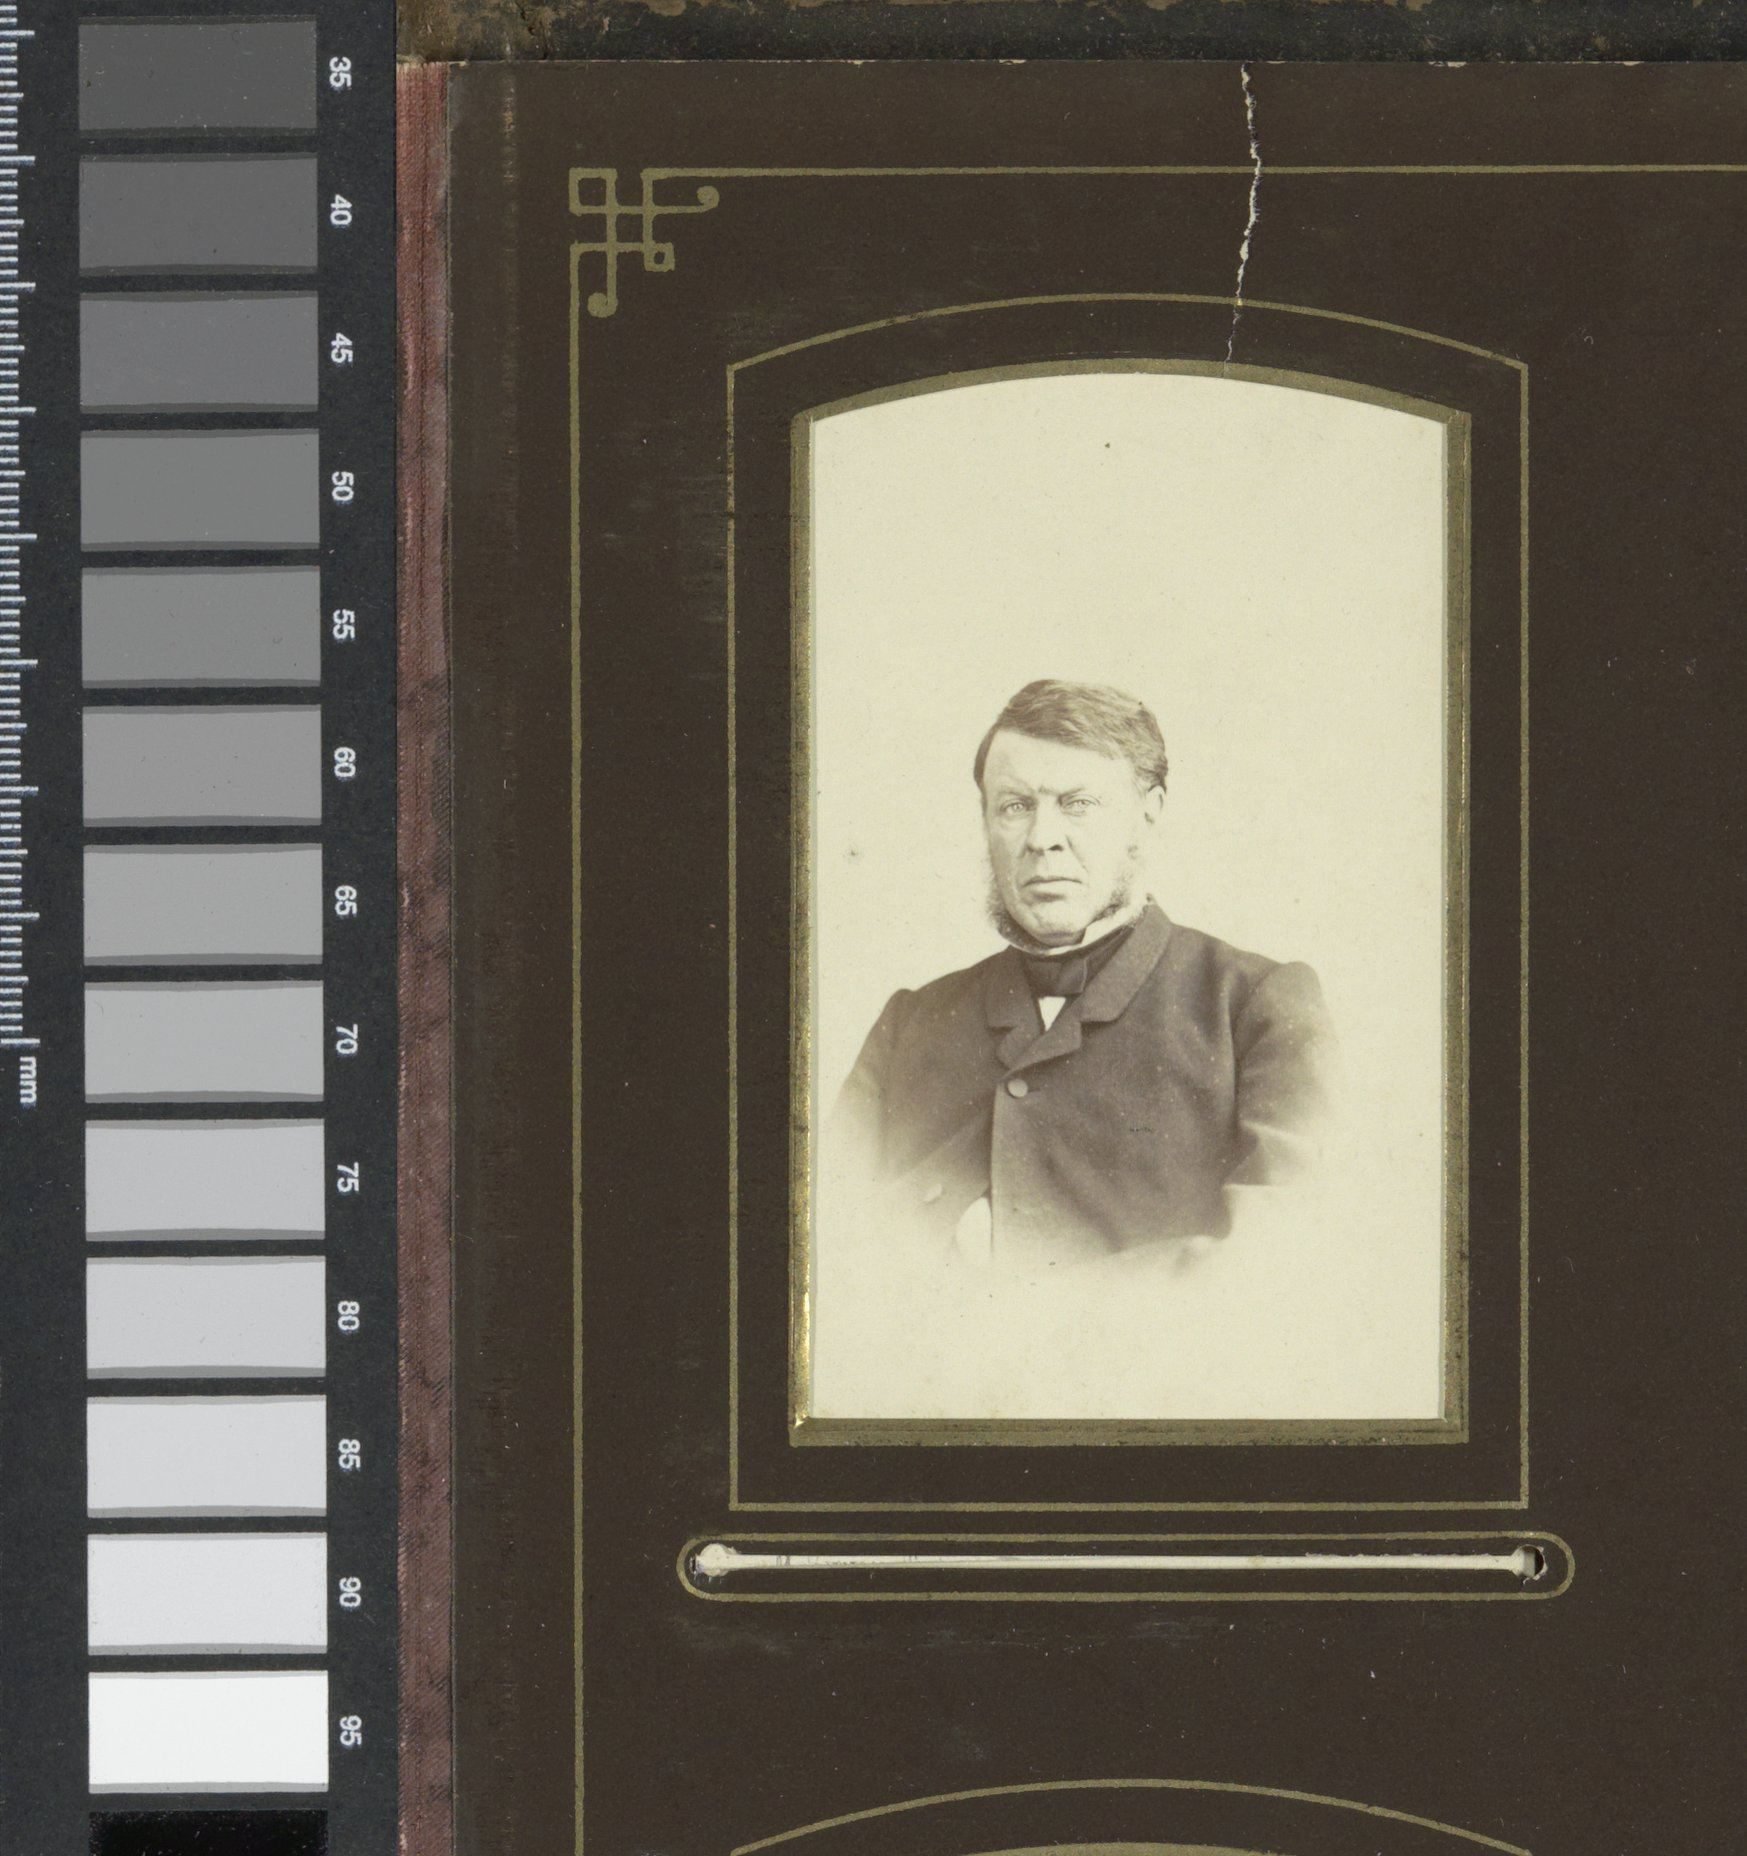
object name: carte de visite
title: Portret van een man met bakkebaarden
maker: maurits verveer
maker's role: painter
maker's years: 1817-1903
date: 1864-1890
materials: cardboard, paper, photographic support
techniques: albumen print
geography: the hague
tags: sideburns, adult man, historical persons not known by name, the hague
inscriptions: address: ‘52. Zeestraat 52, vis á vis du Willemspark, La Haye.’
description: Onderdeel van Fotoalbum van de families Matthes, Doorman en Van Thiel.